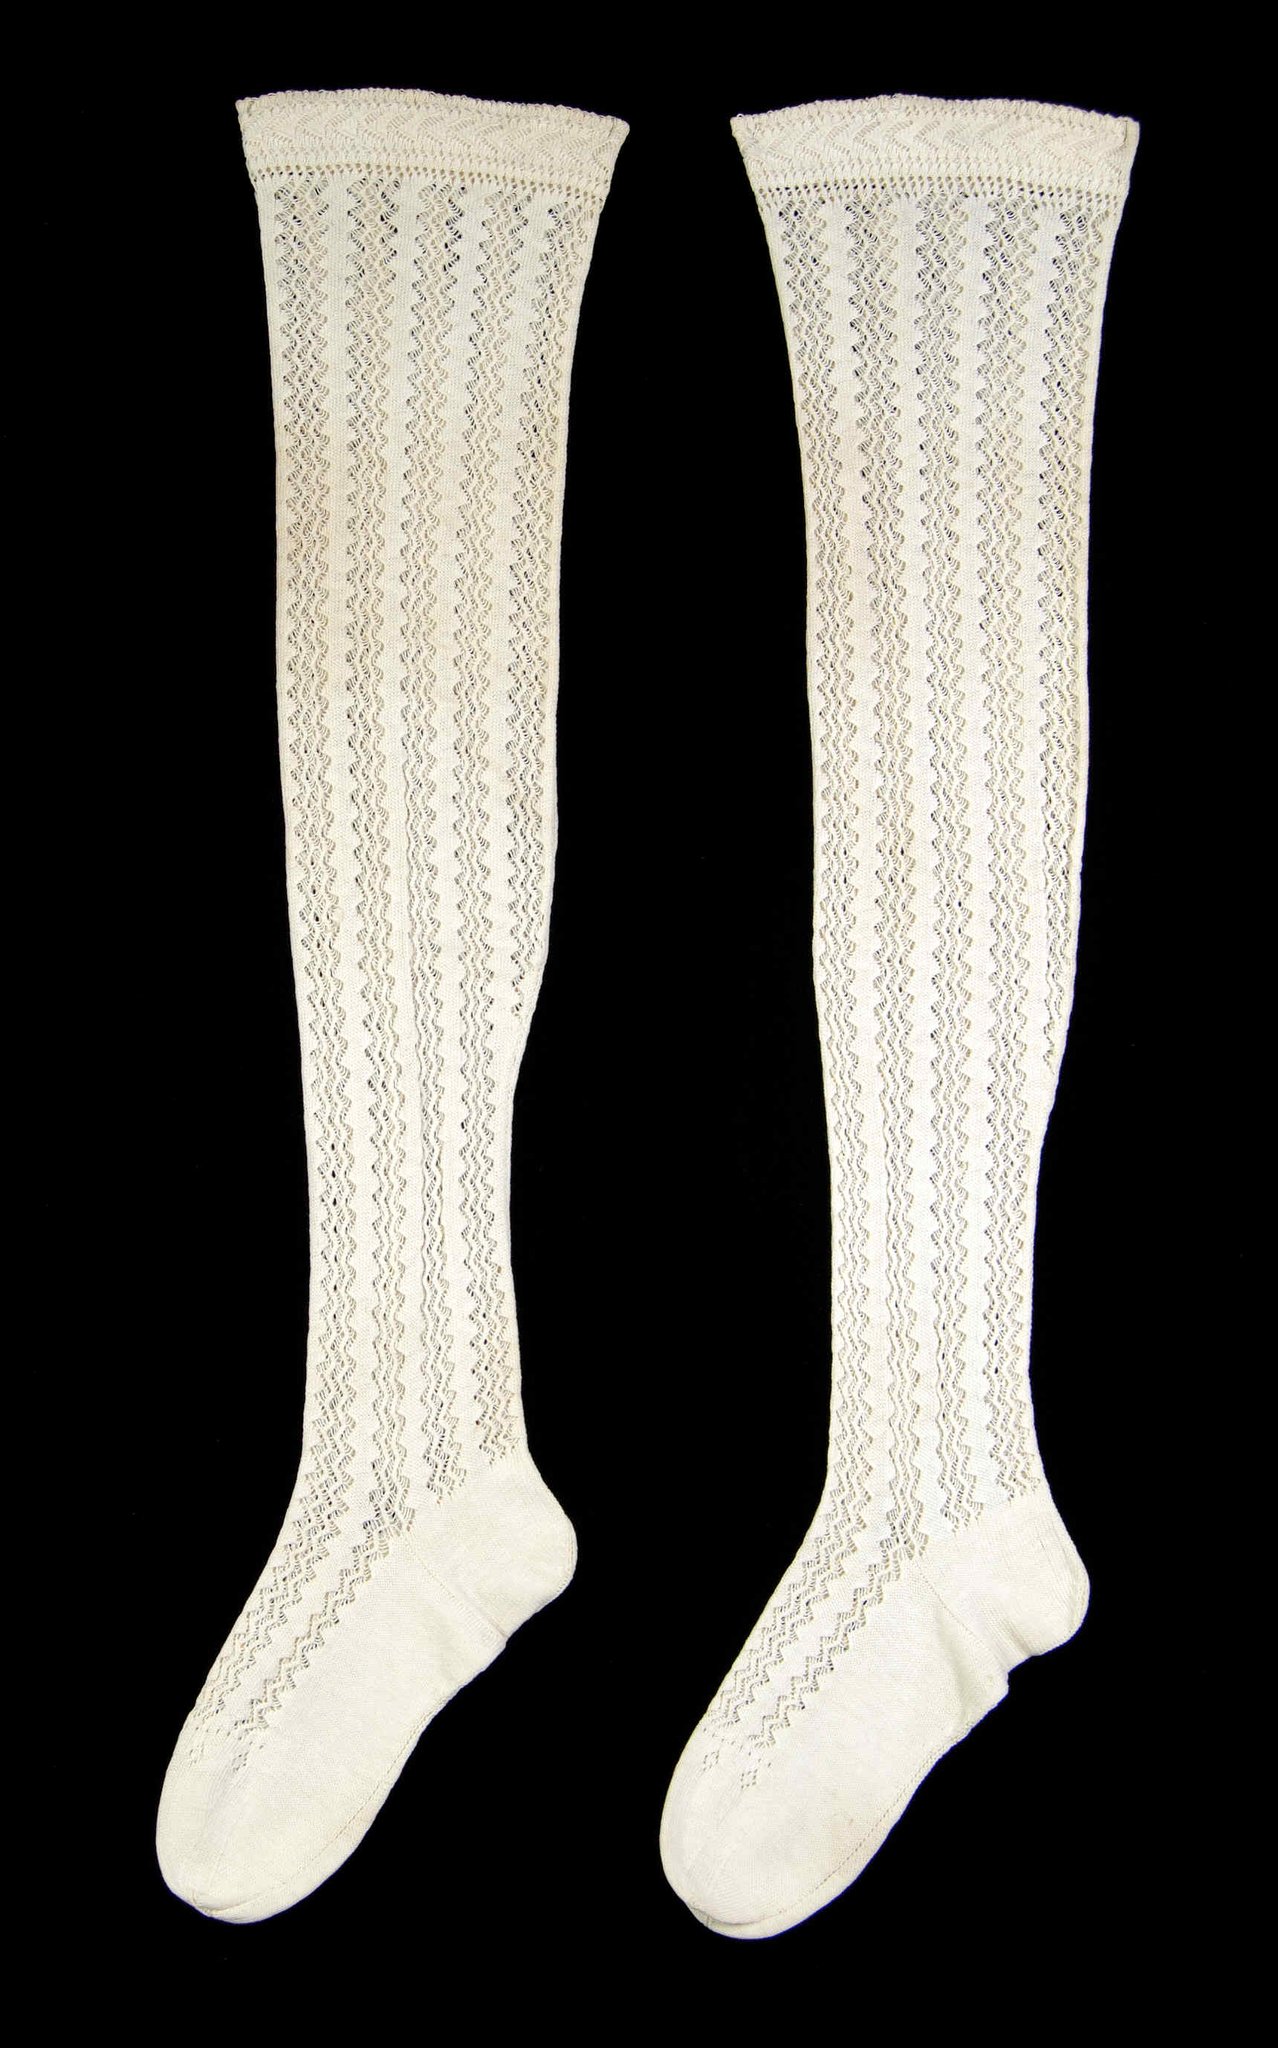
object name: stocking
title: Stockings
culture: american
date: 1876-1900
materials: linen